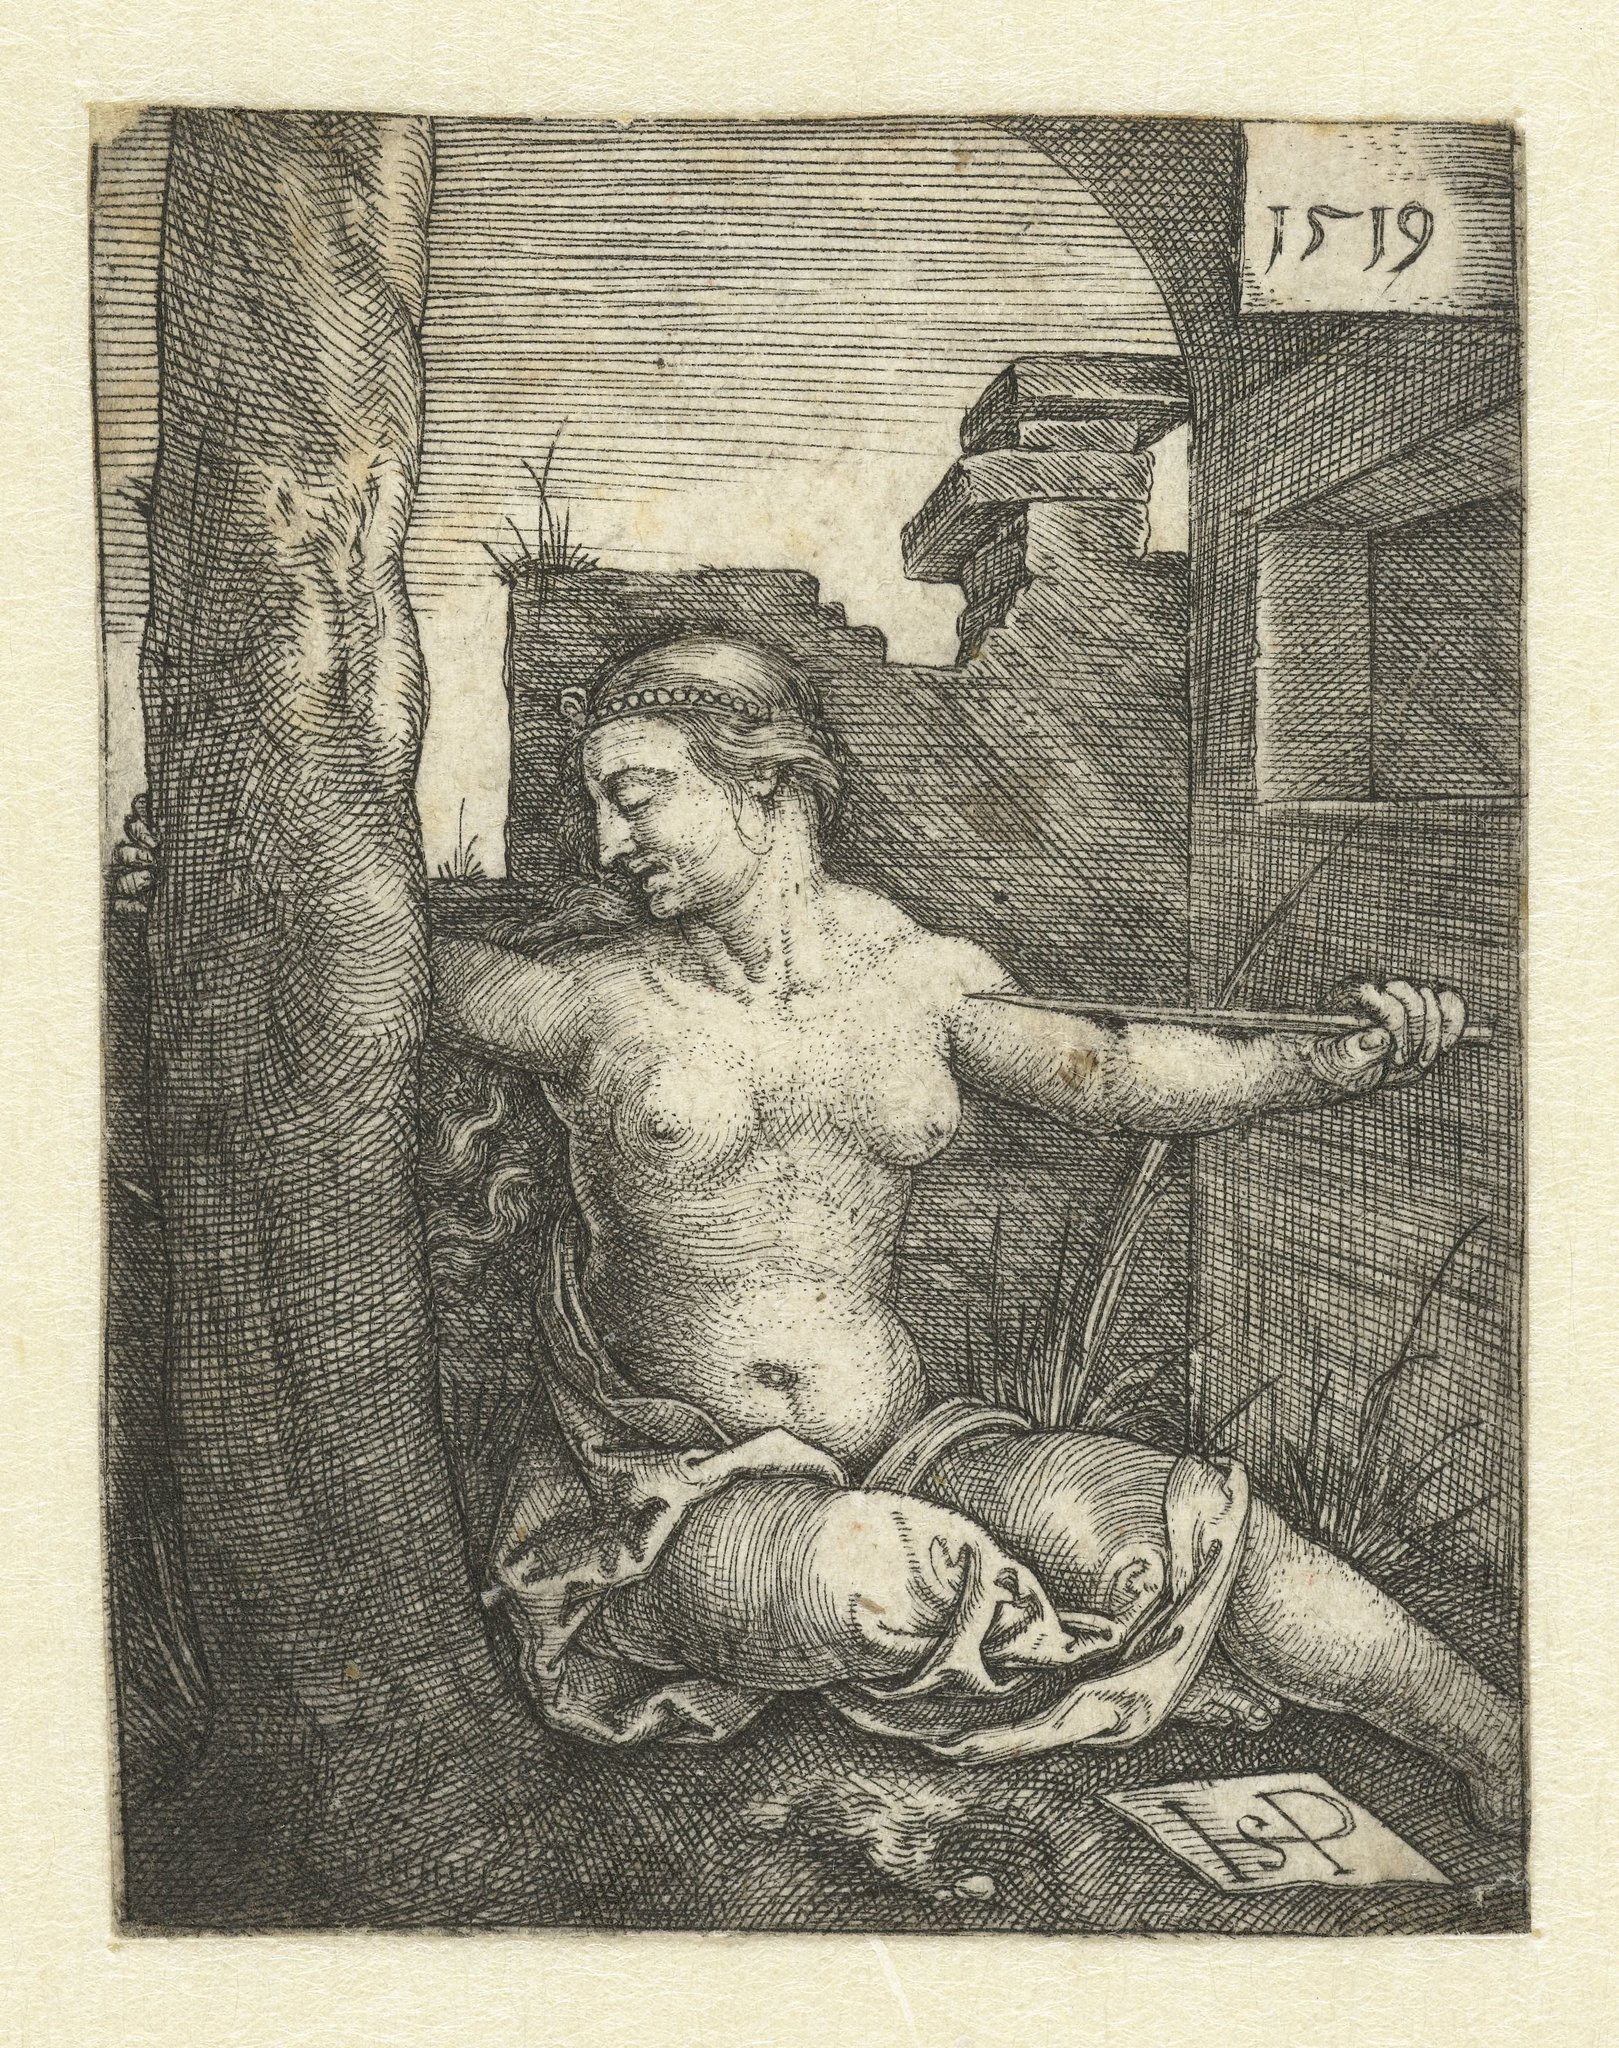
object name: print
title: Dood van Lucretia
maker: hans sebald beham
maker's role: designer, draughtsman, print maker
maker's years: 1500-1550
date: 1519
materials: paper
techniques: engraving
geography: nuremberg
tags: death of lucretia: she commits suicide by stabbing herself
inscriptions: collector's mark: Lugt 2228a